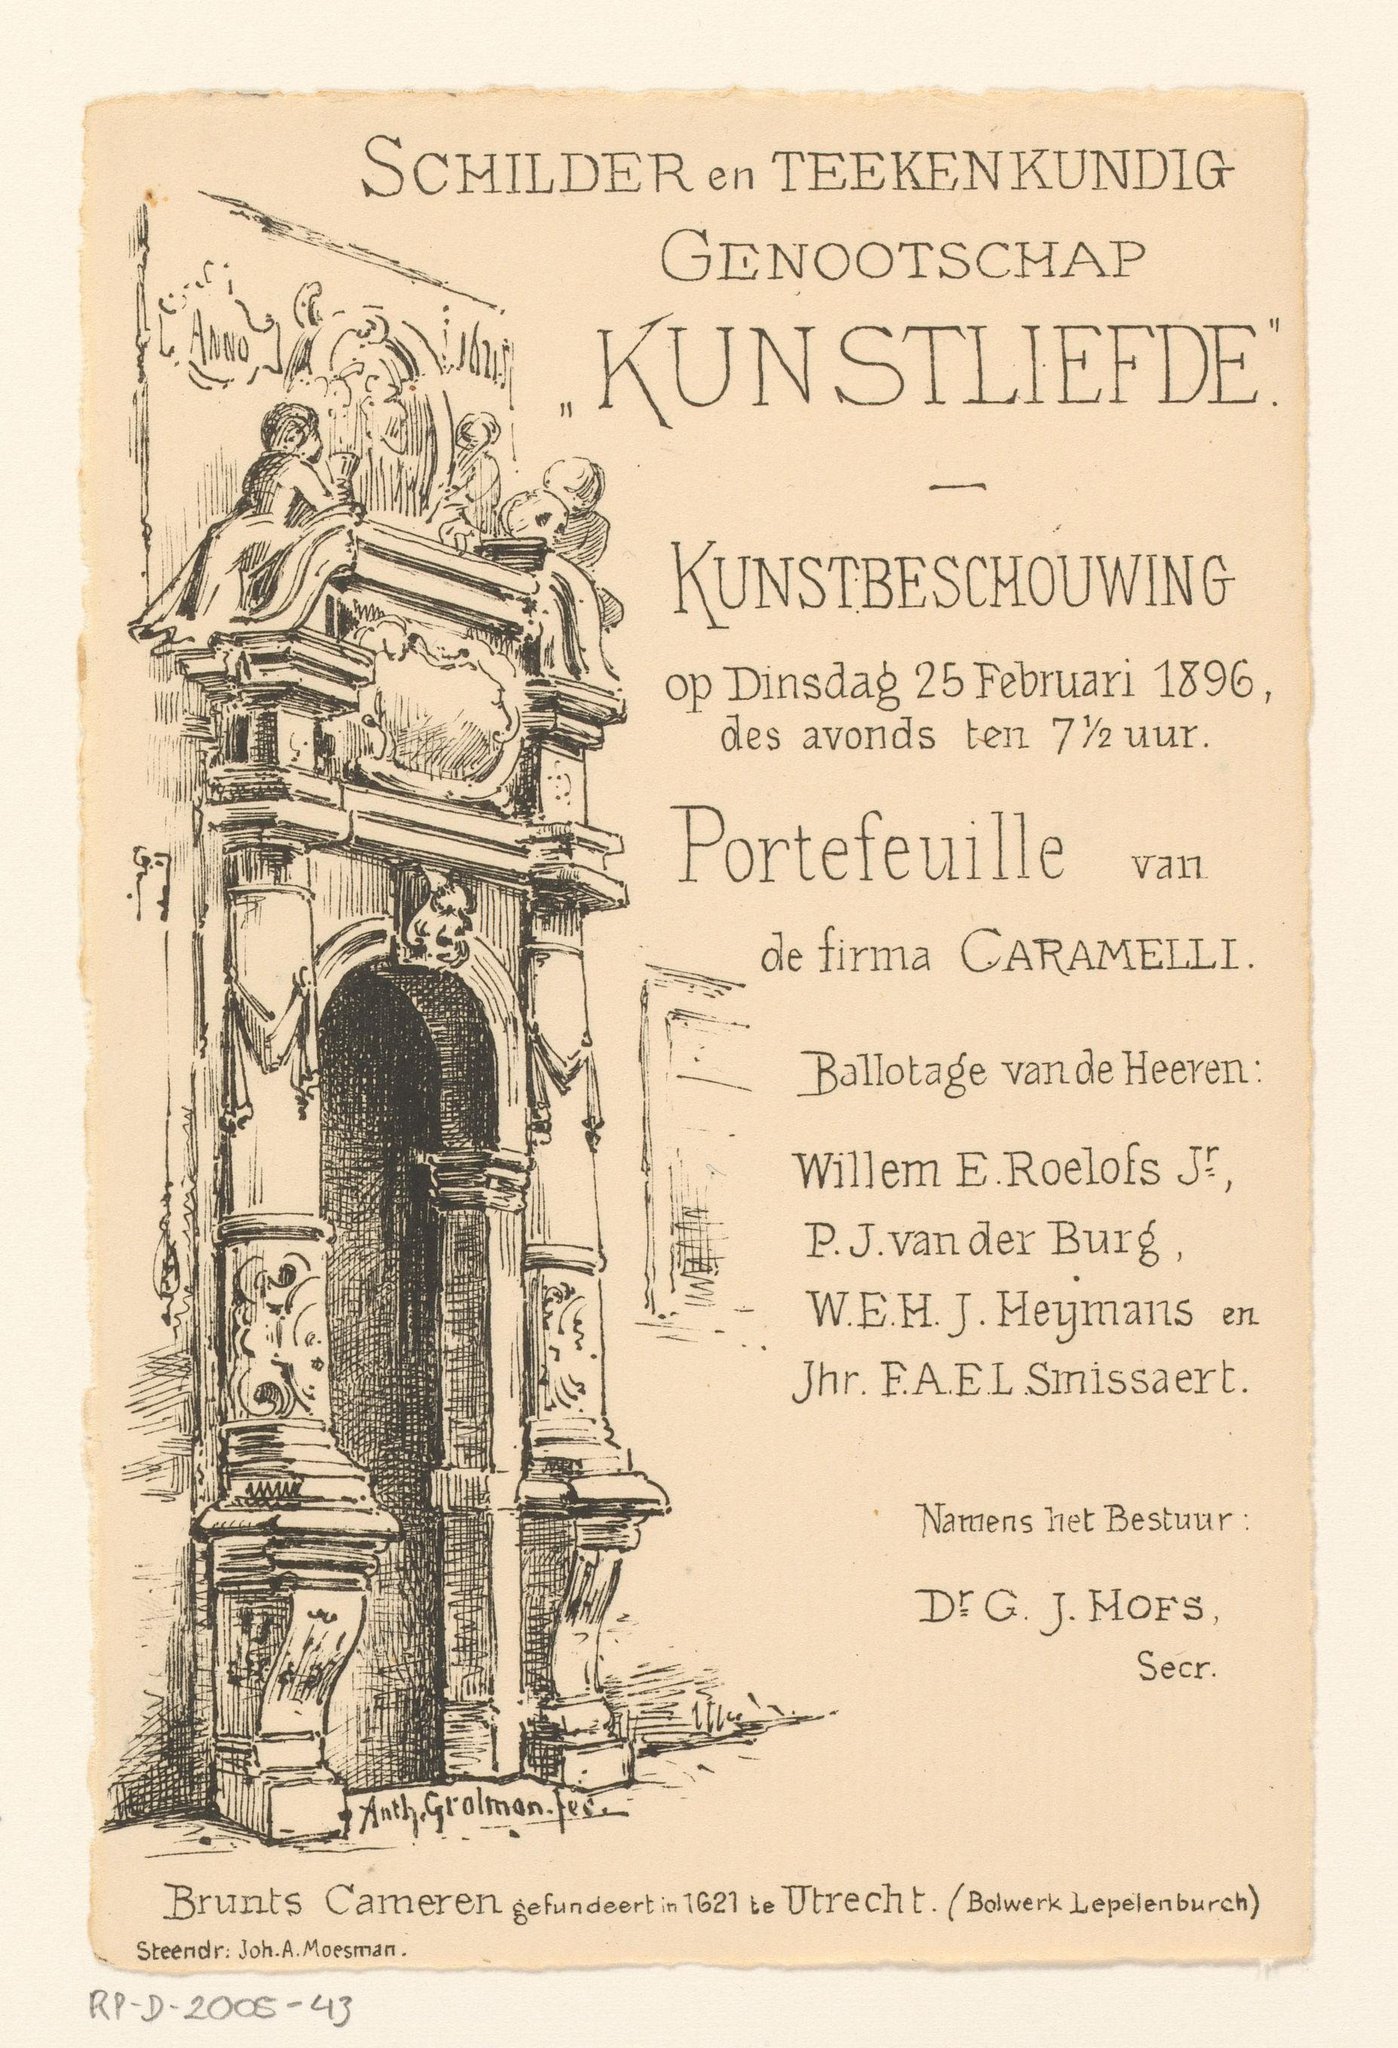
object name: invitation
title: Uitnodiging van Schilder- en Teekenkundig Genootschap "Kunstliefde" voor een kunstbeschouwing, 25 februari 1896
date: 1802-1896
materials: paper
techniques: lithograph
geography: netherlands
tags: criticizing and discussing art, art criticism, circle, club of artists, collecting and exhibiting products of the fine arts, gate, entrance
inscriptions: collector's mark: Lugt 2228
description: Poort van de Bruntskameren op bolwerk Lepelenburg, Utrecht. Uitnodiging van Schilder- en Teekenkundig Genootschap "Kunstliefde" voor een kunstbeschouwing op 25 februari 1896 van de portefeuille van de firma Caramelli.